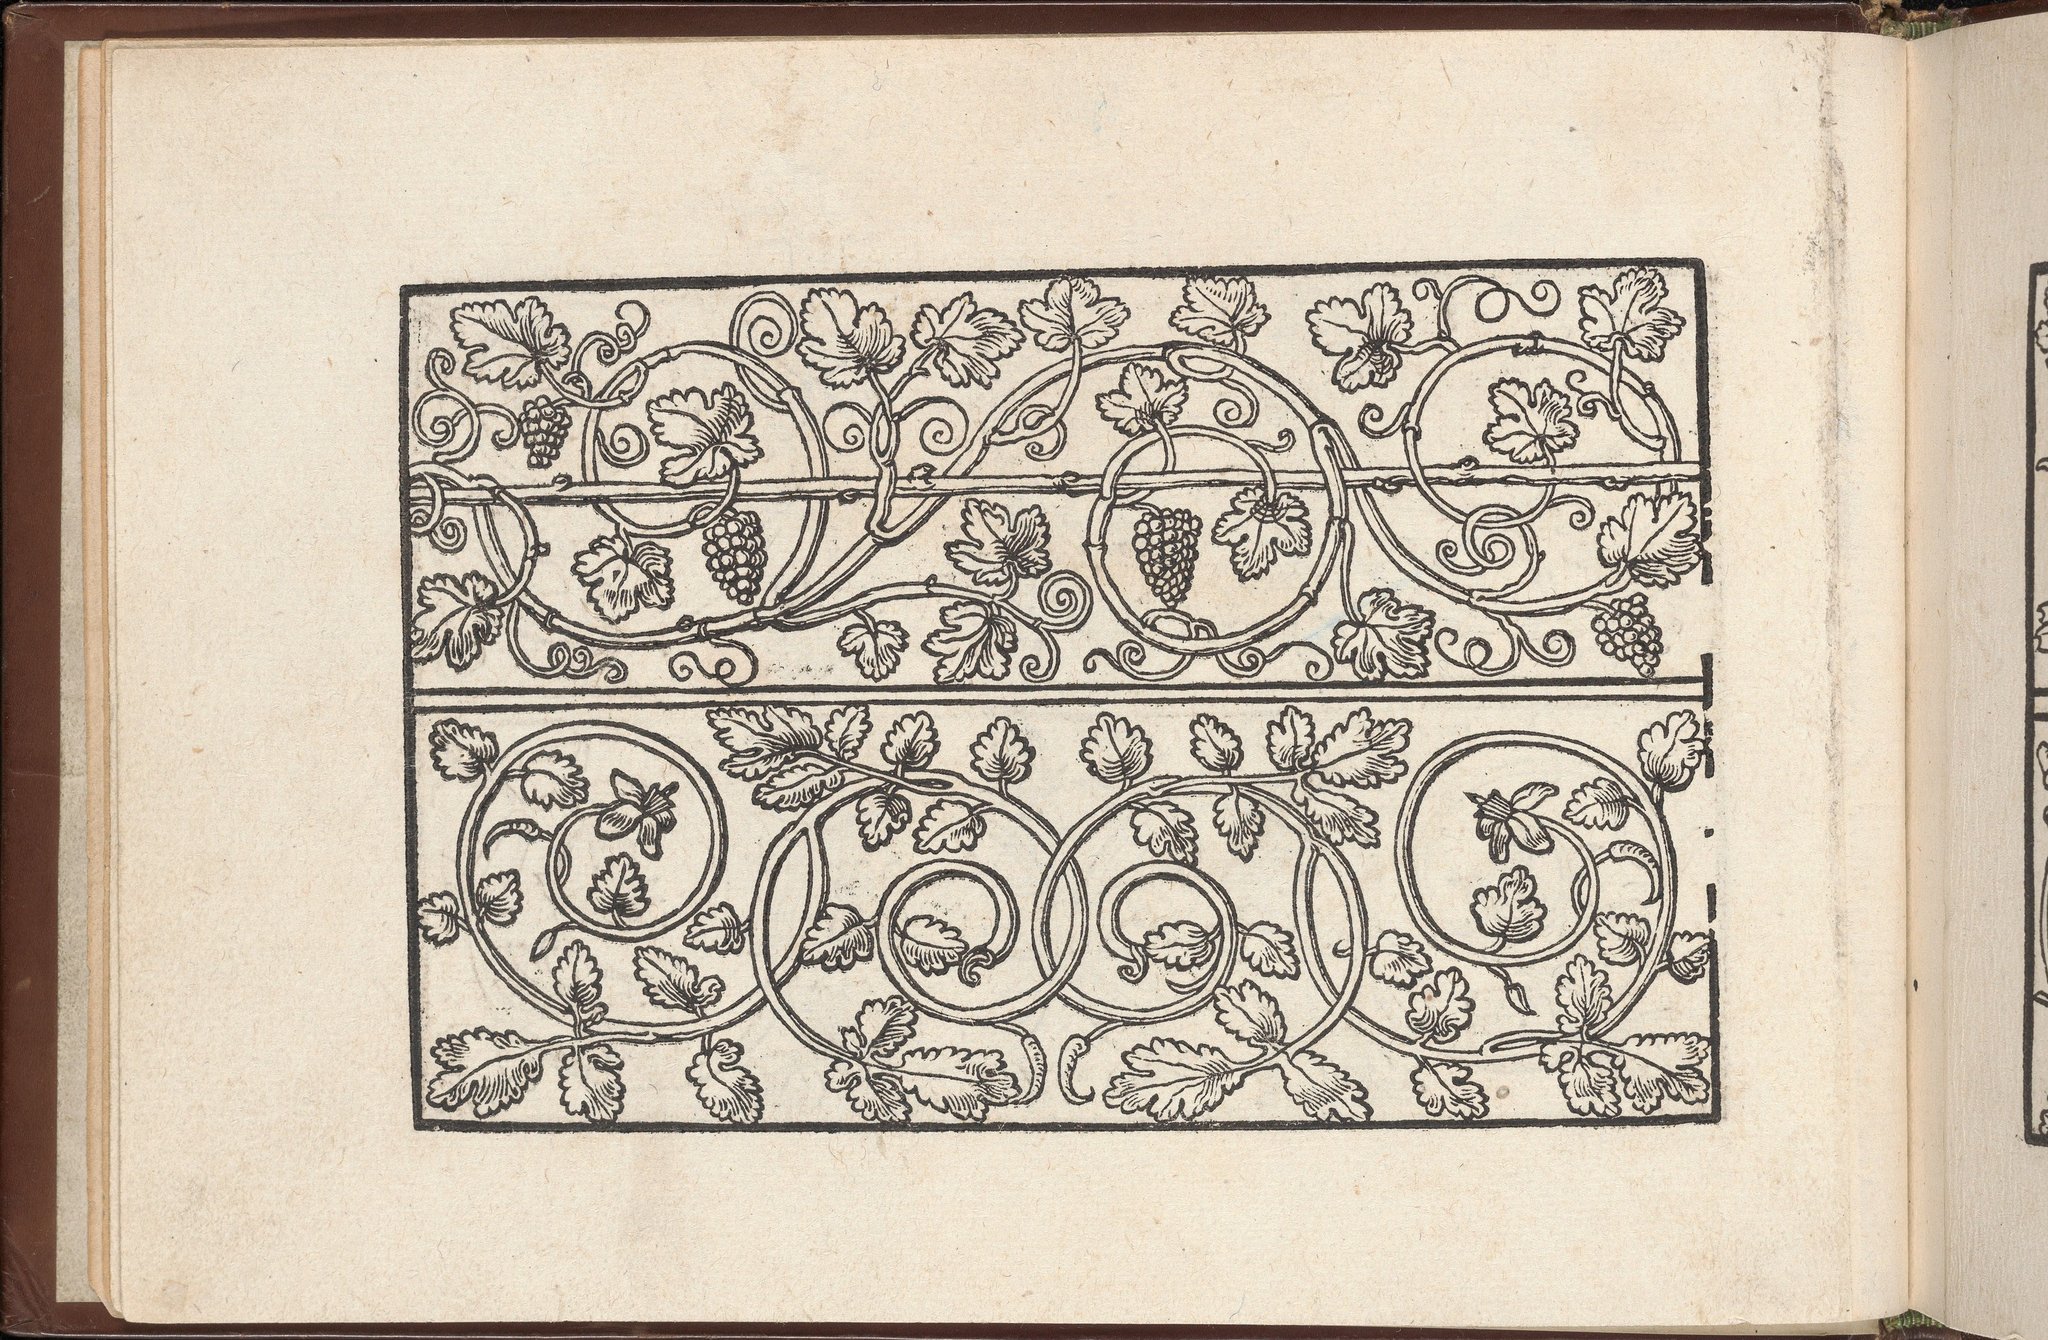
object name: book print ornament architecture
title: Page from Eyn Newe kunstlich moetdelboech alle kunst (Page 2v)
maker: peter quentel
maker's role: publisher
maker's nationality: german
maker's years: 1500-1550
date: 1532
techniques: woodcut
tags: grapes,vines